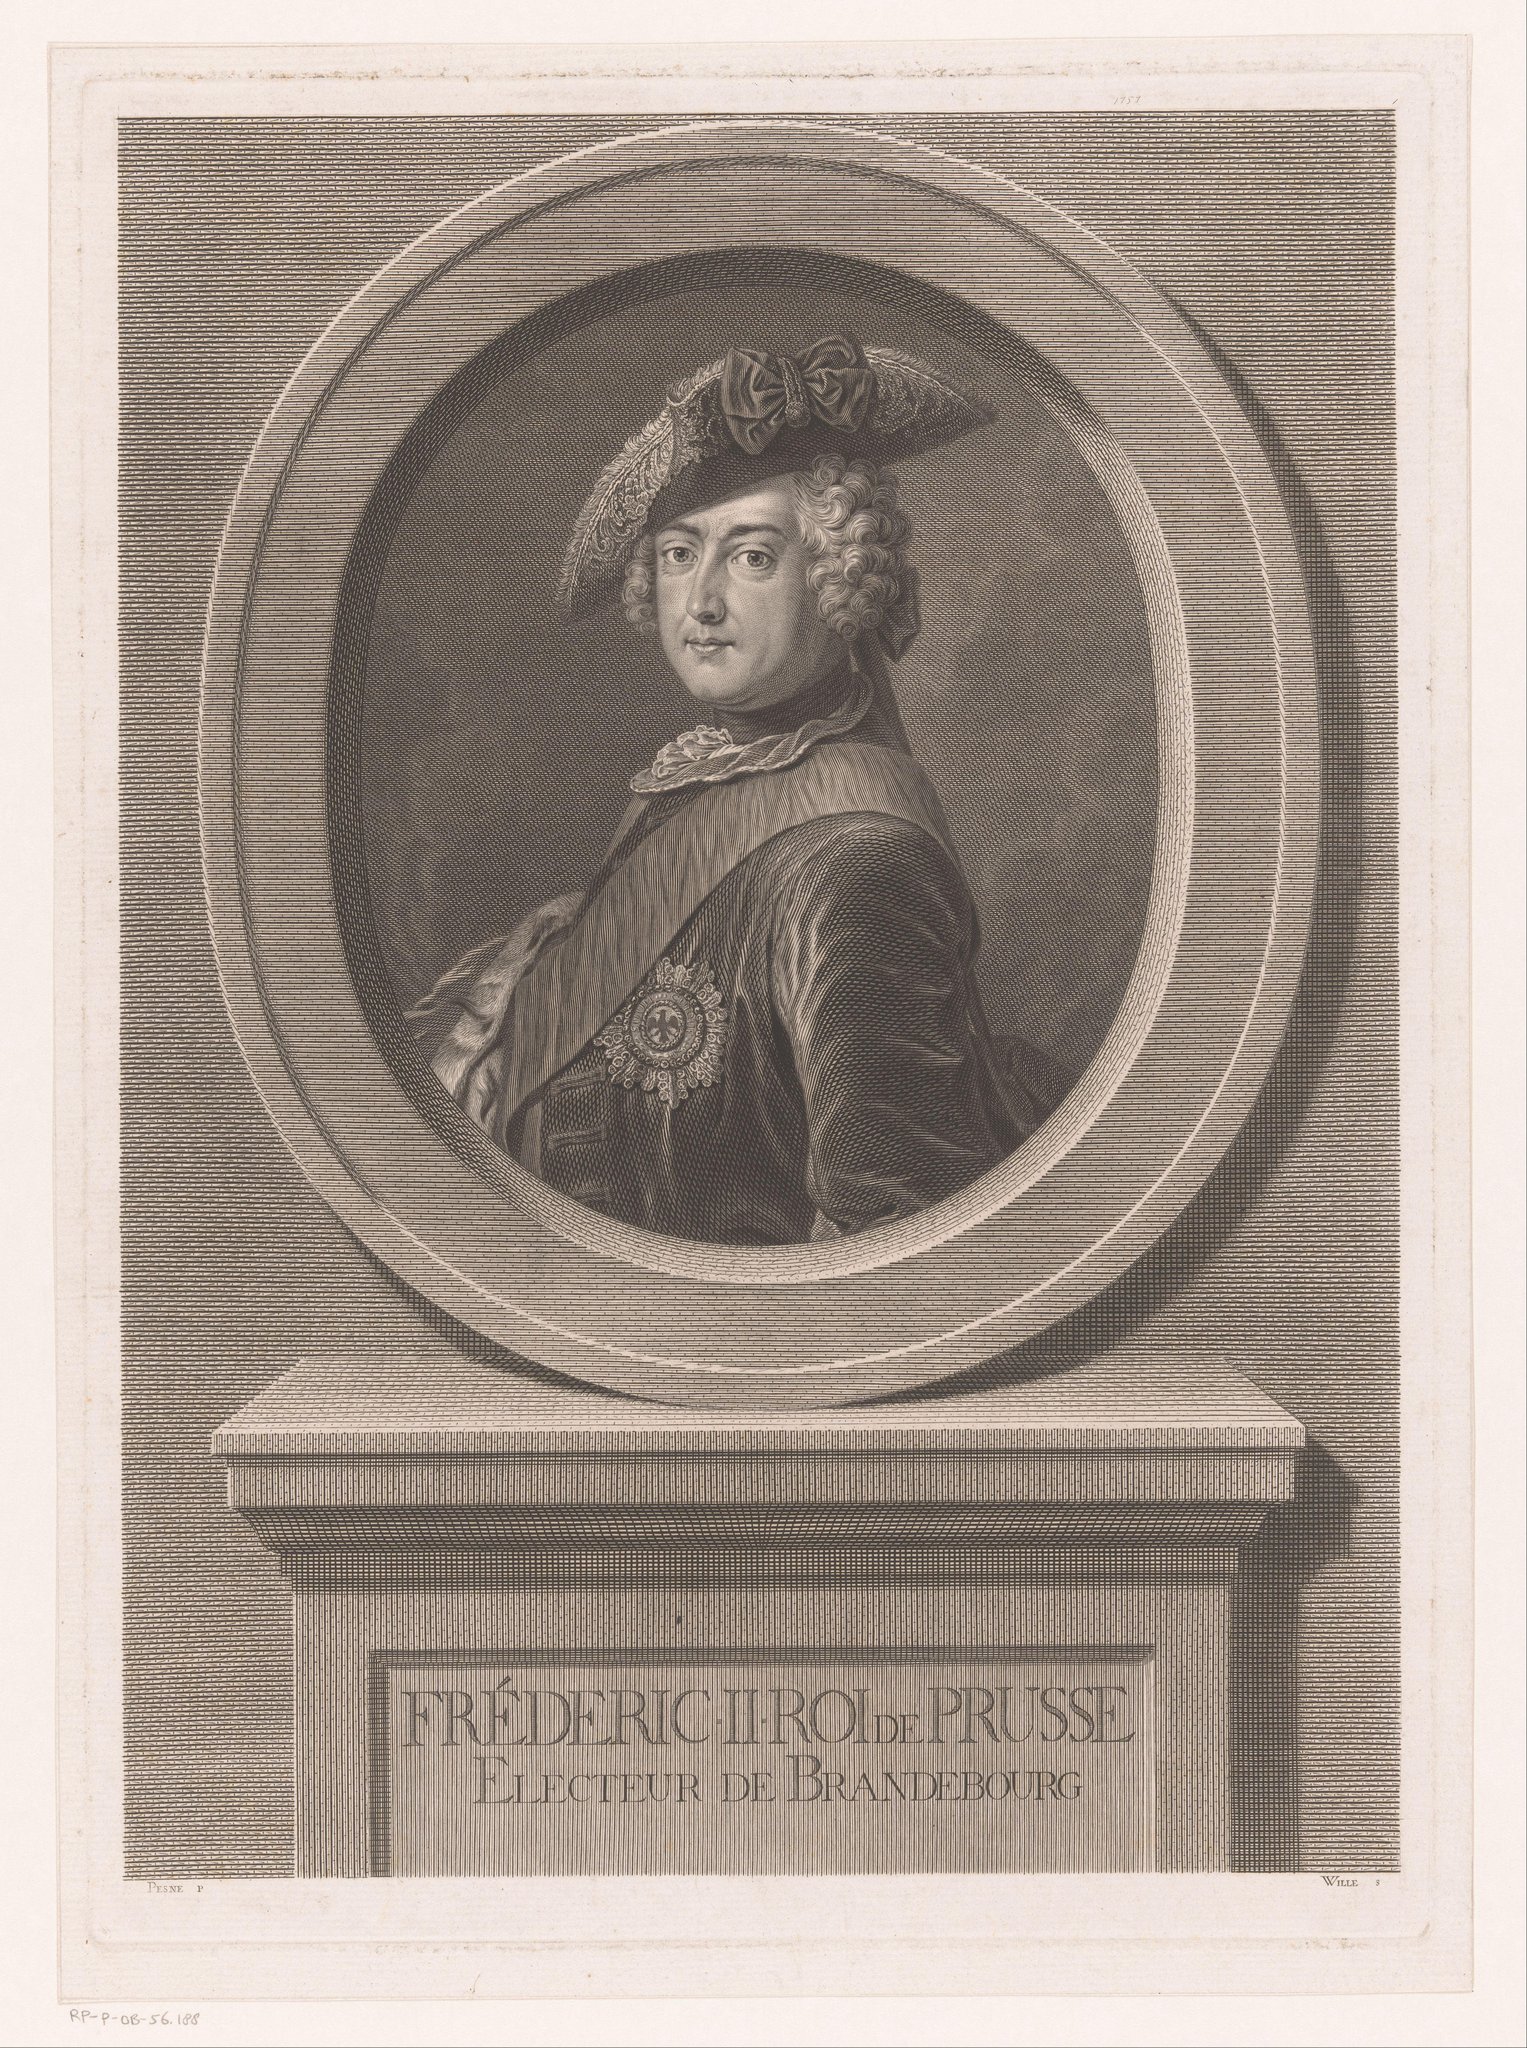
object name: print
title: Portret van Frederik de Grote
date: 1757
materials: paper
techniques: engraving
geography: germany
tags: berlin, frederick ii (king of prussia), historical persons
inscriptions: collector's mark: Lugt 240